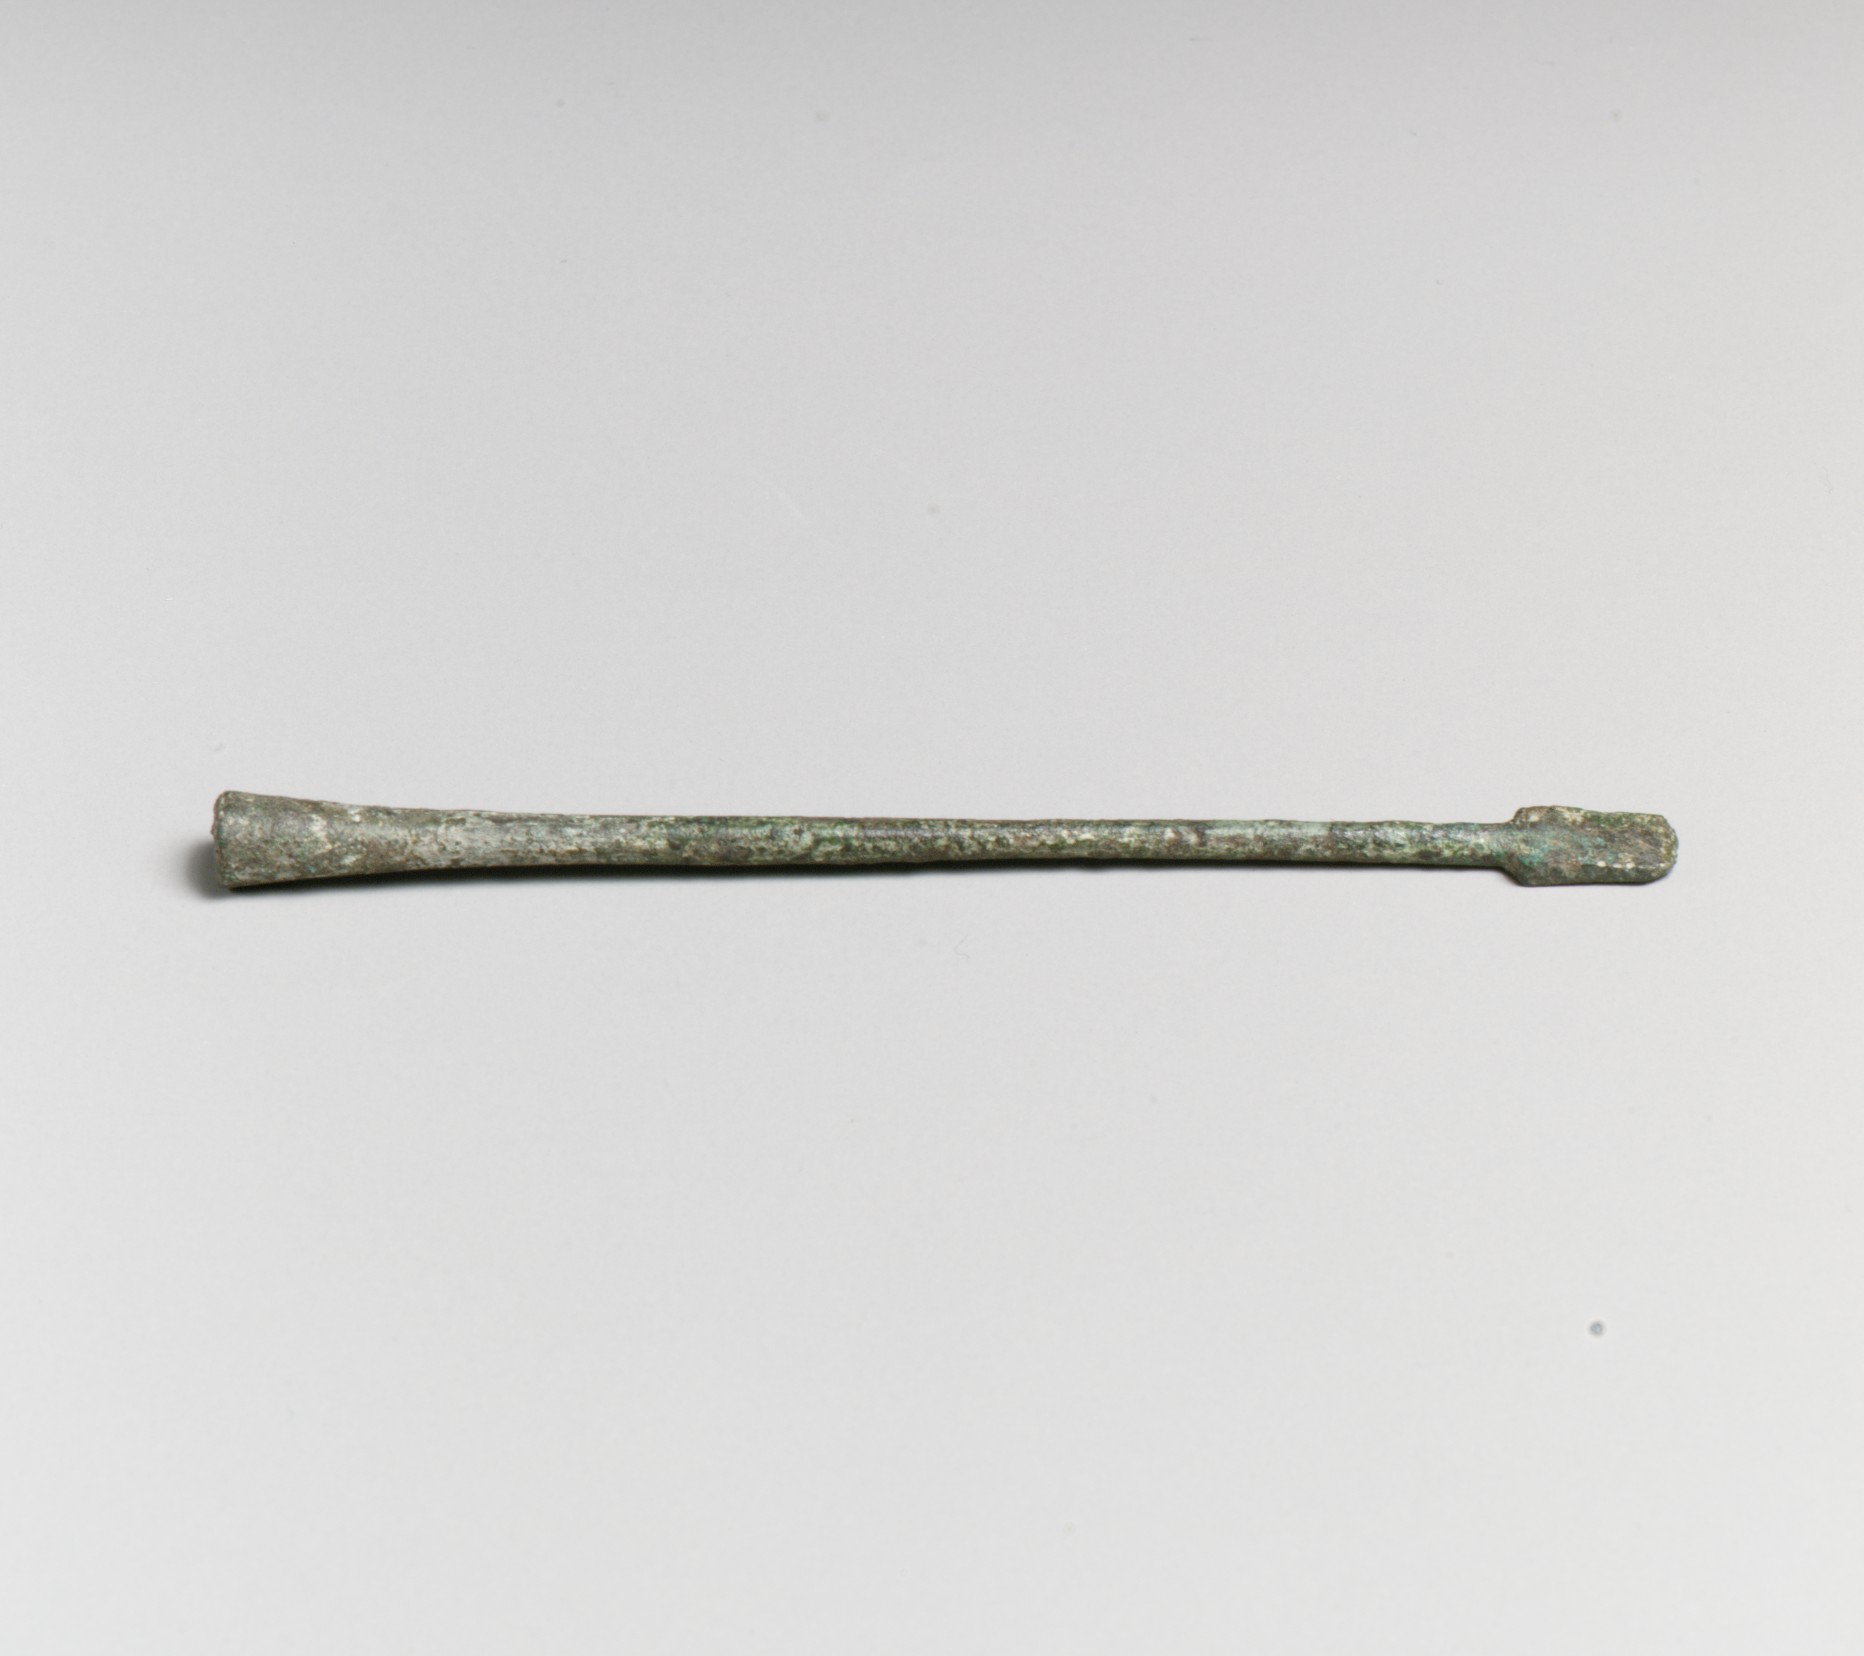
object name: chisel or ligula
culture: roman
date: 670 BCE-330 CE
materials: bronze